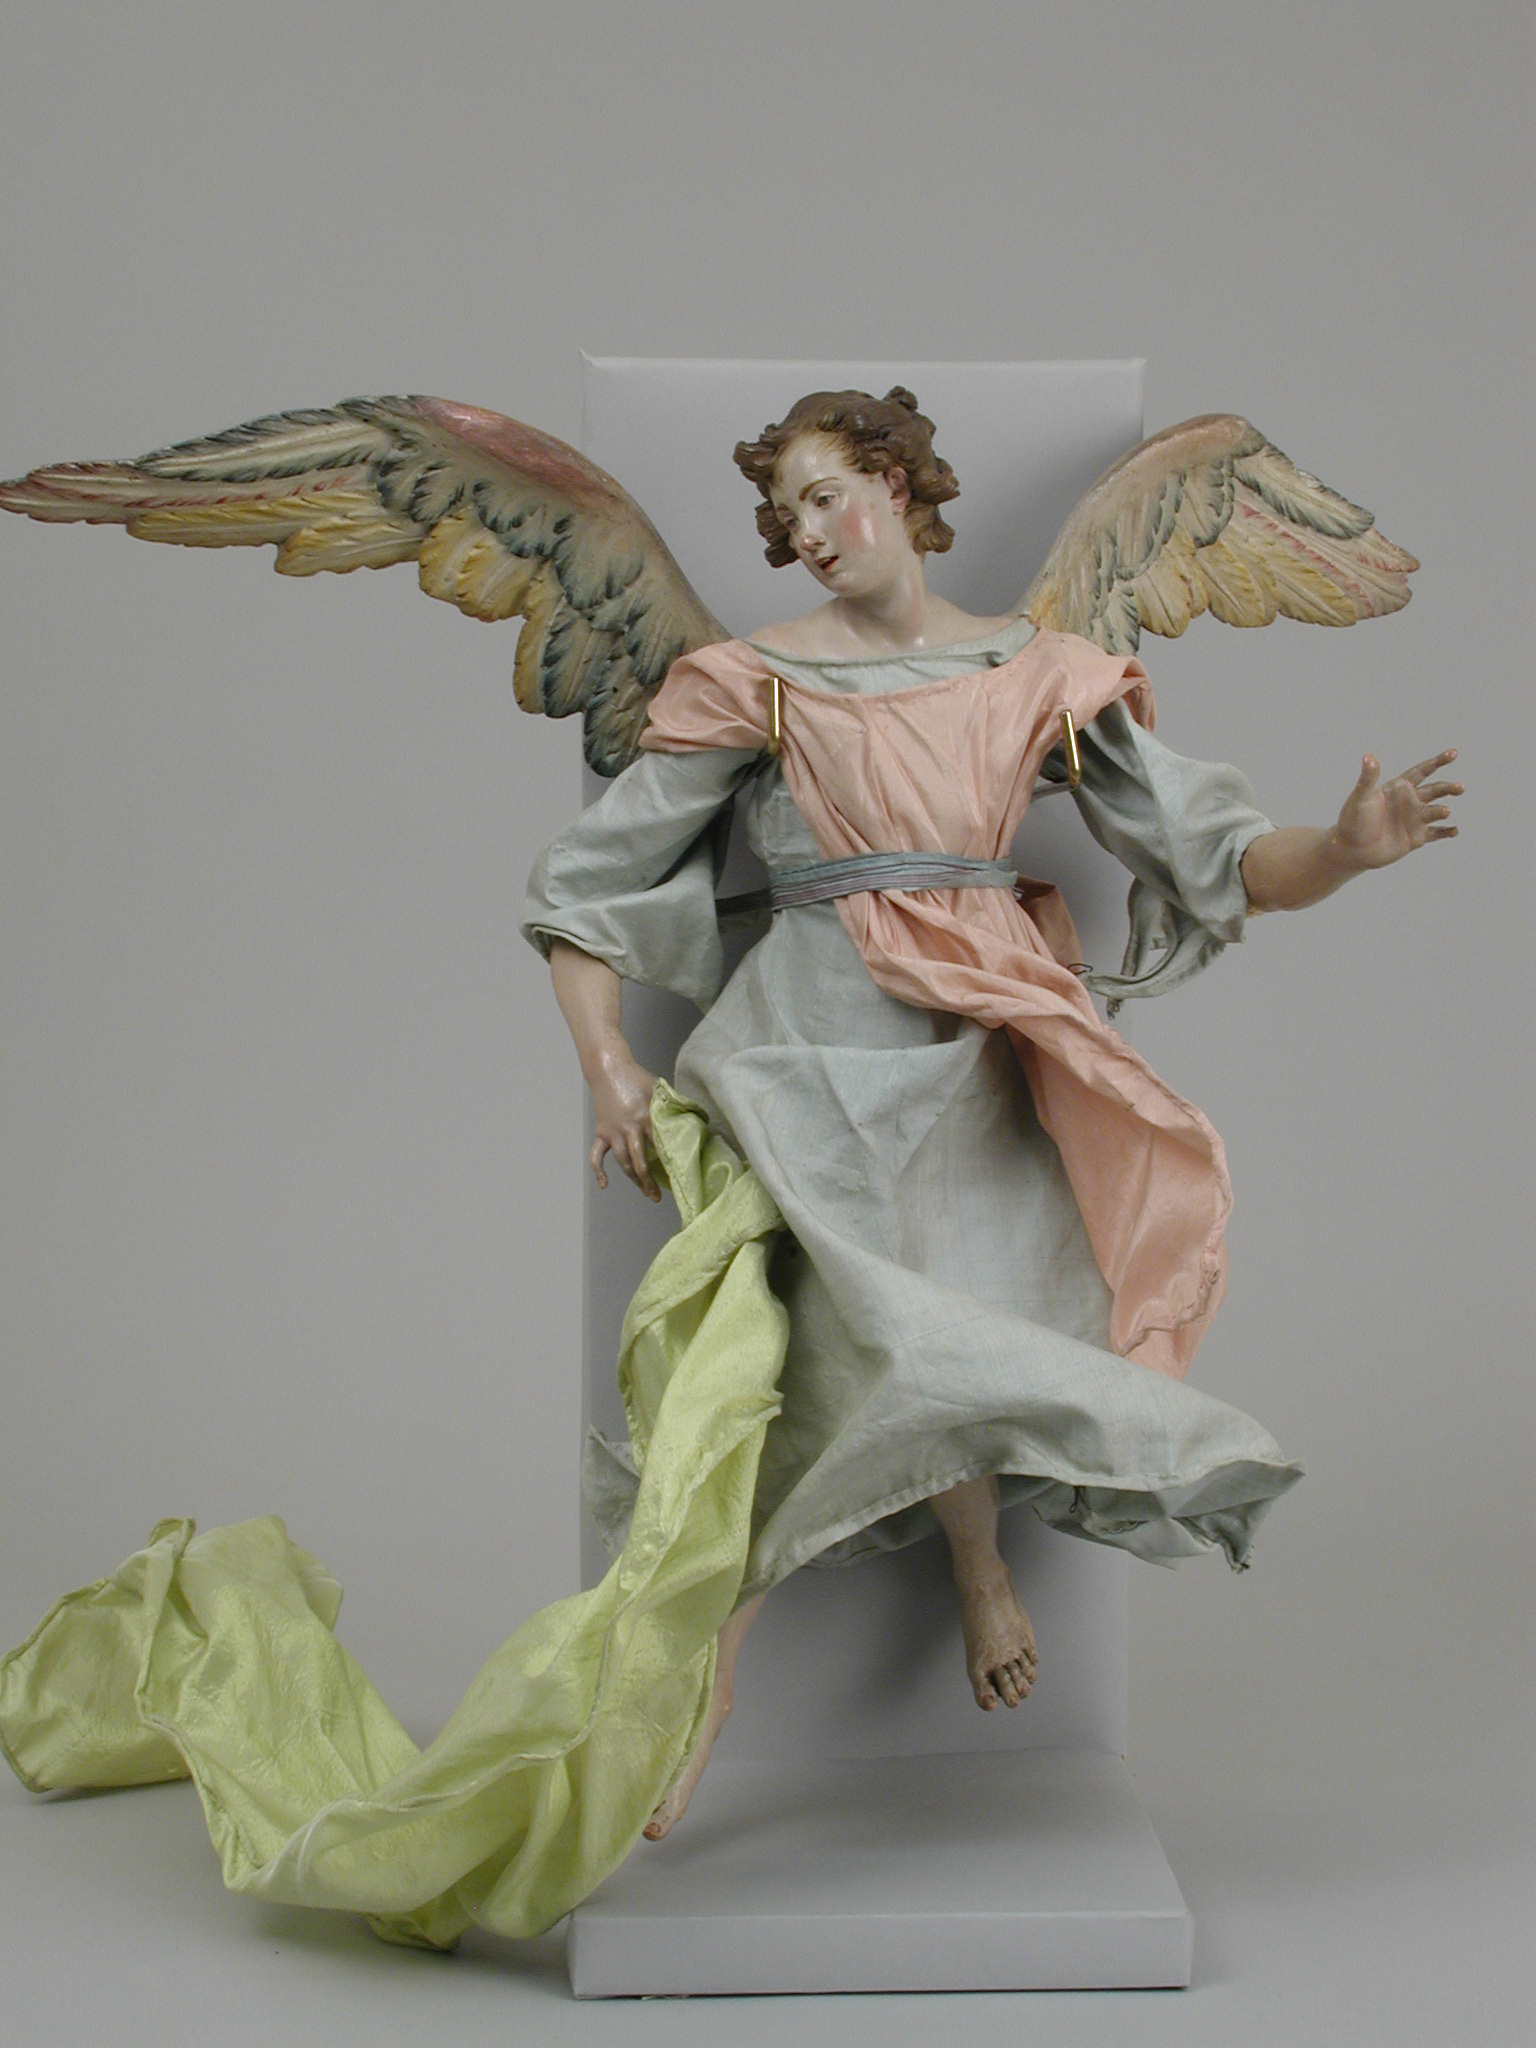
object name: crèche figure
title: Angel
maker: giuseppe gori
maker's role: maker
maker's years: 1770-1810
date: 1751-1800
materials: terracotta, fiber, metal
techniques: polychrome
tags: angels